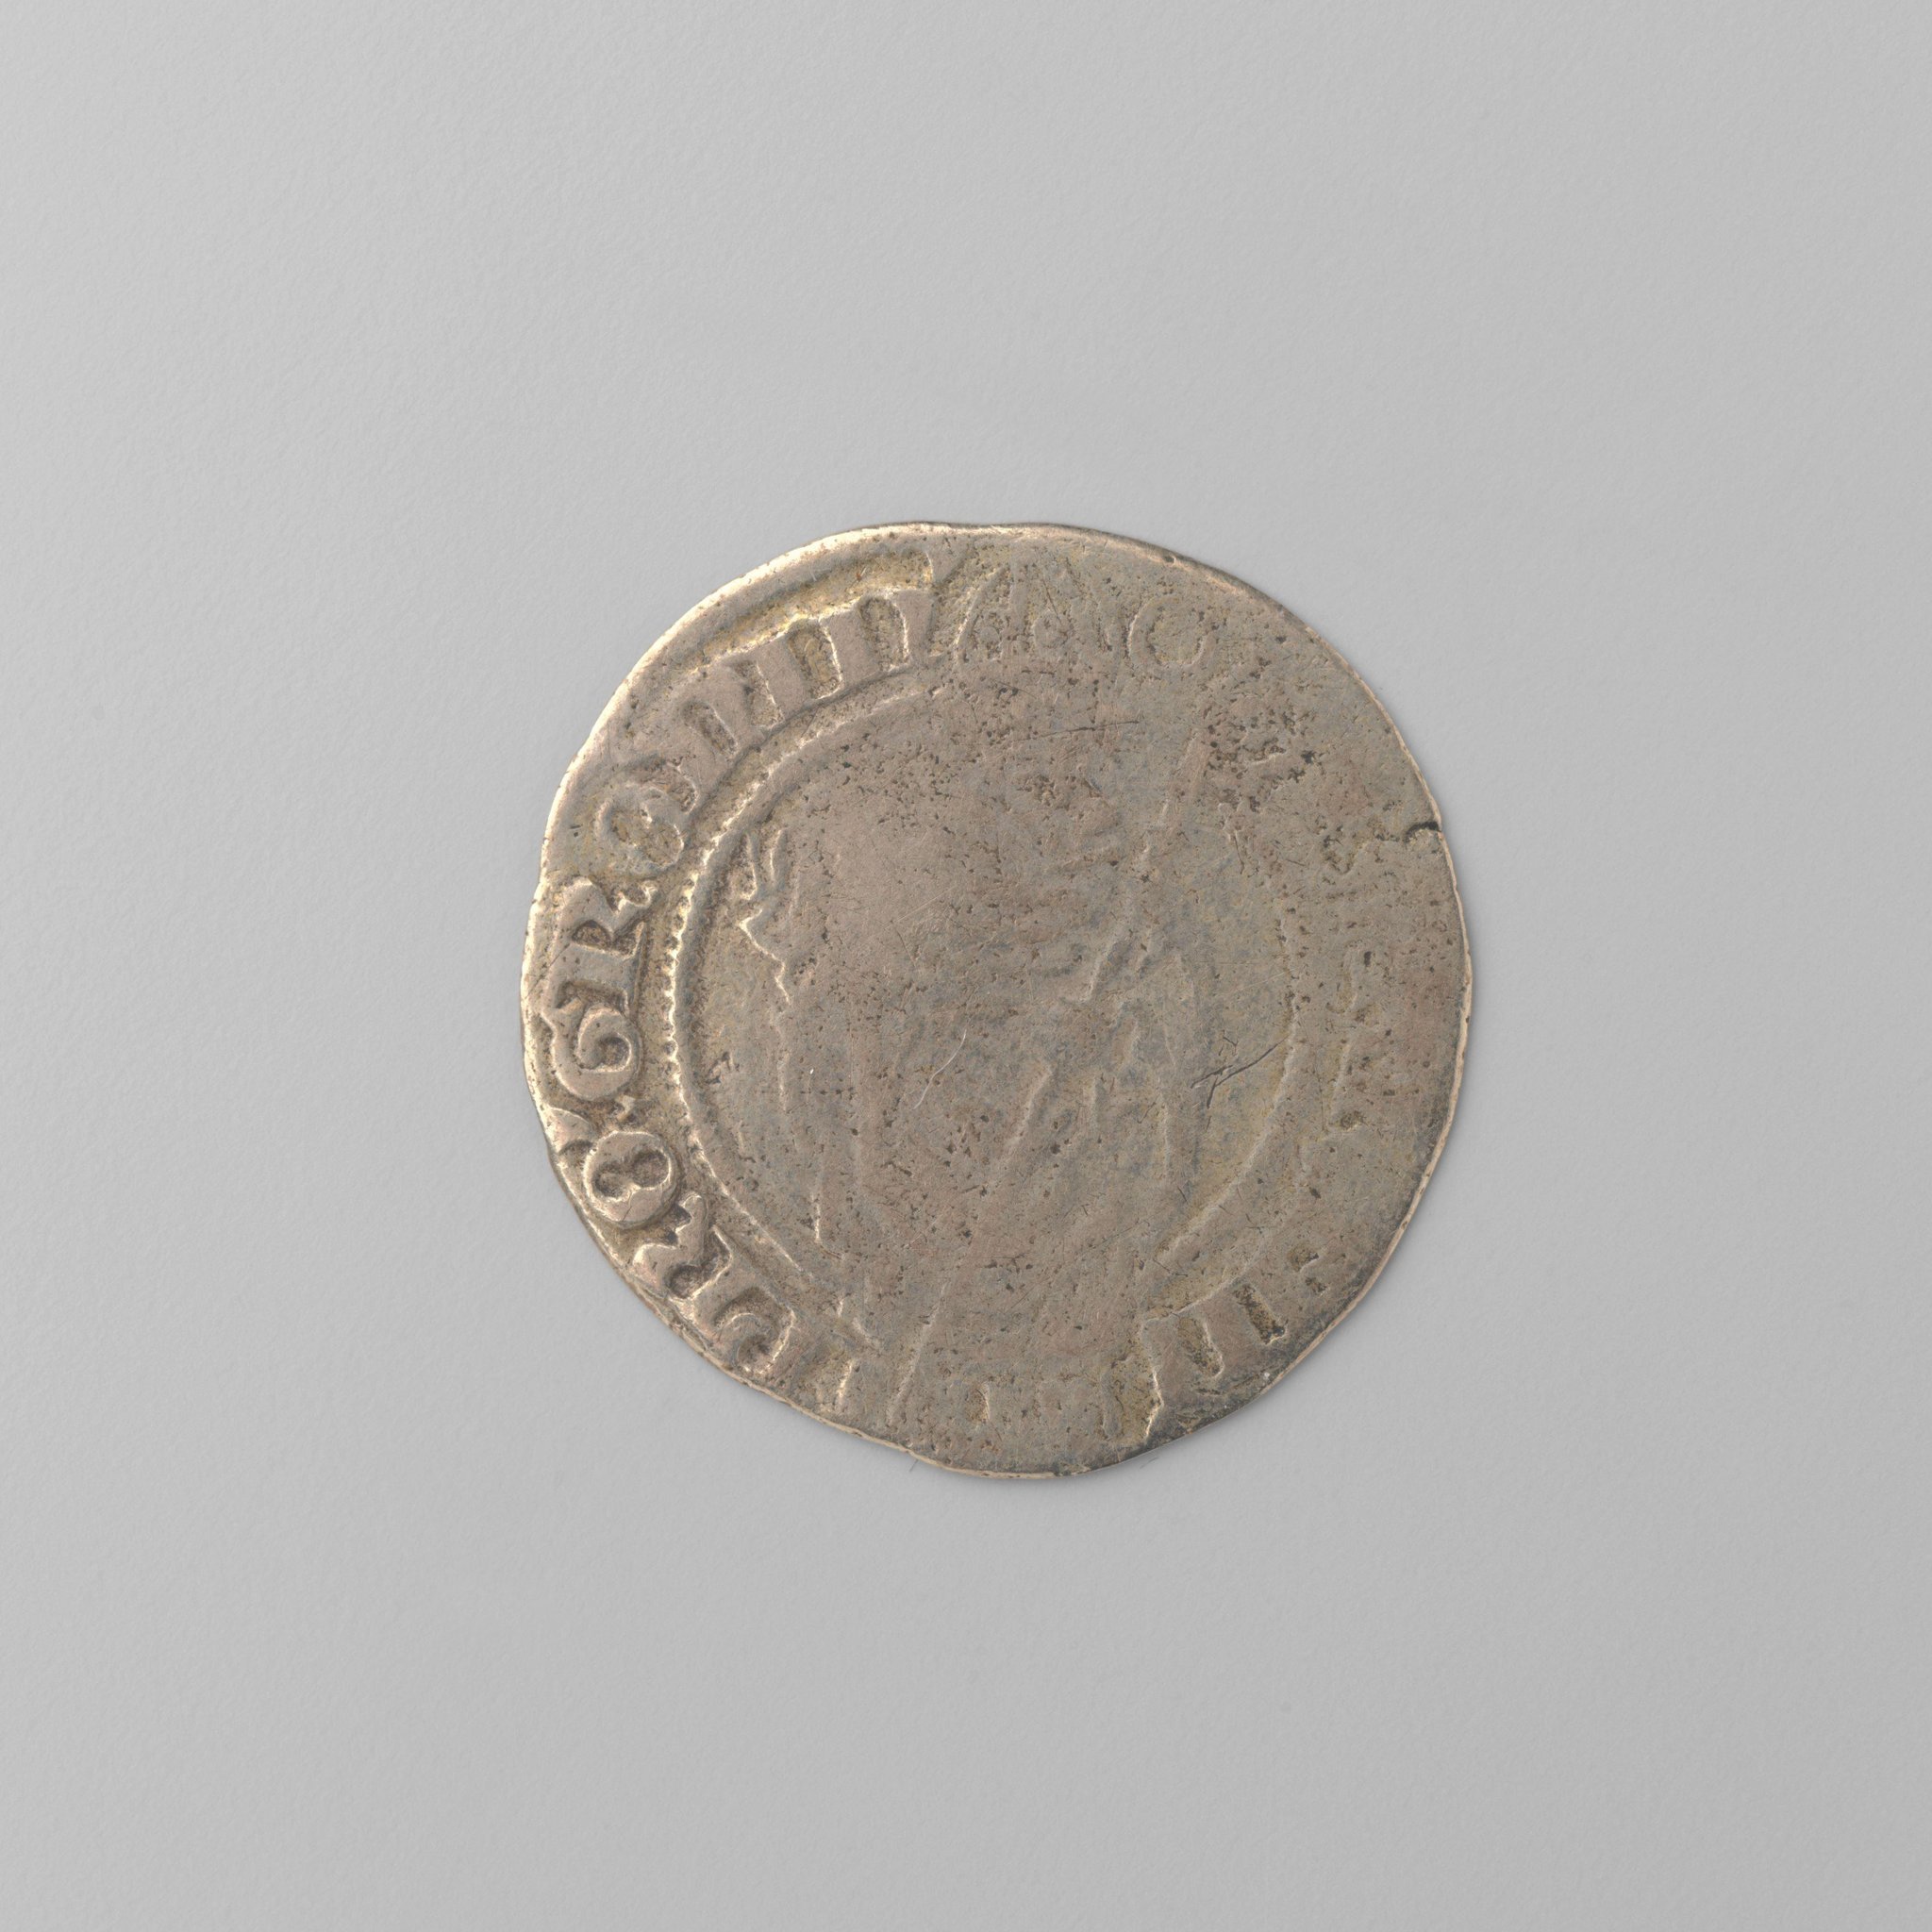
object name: postulaatgulden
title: Groningen, postulaatgulden of knapkoek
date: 1475-1500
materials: gold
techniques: striking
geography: groningen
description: Gouden munt. Voorzijde: in driepas wapenschild van de stad Groningen. Keerzijde: staande heilige met staf.